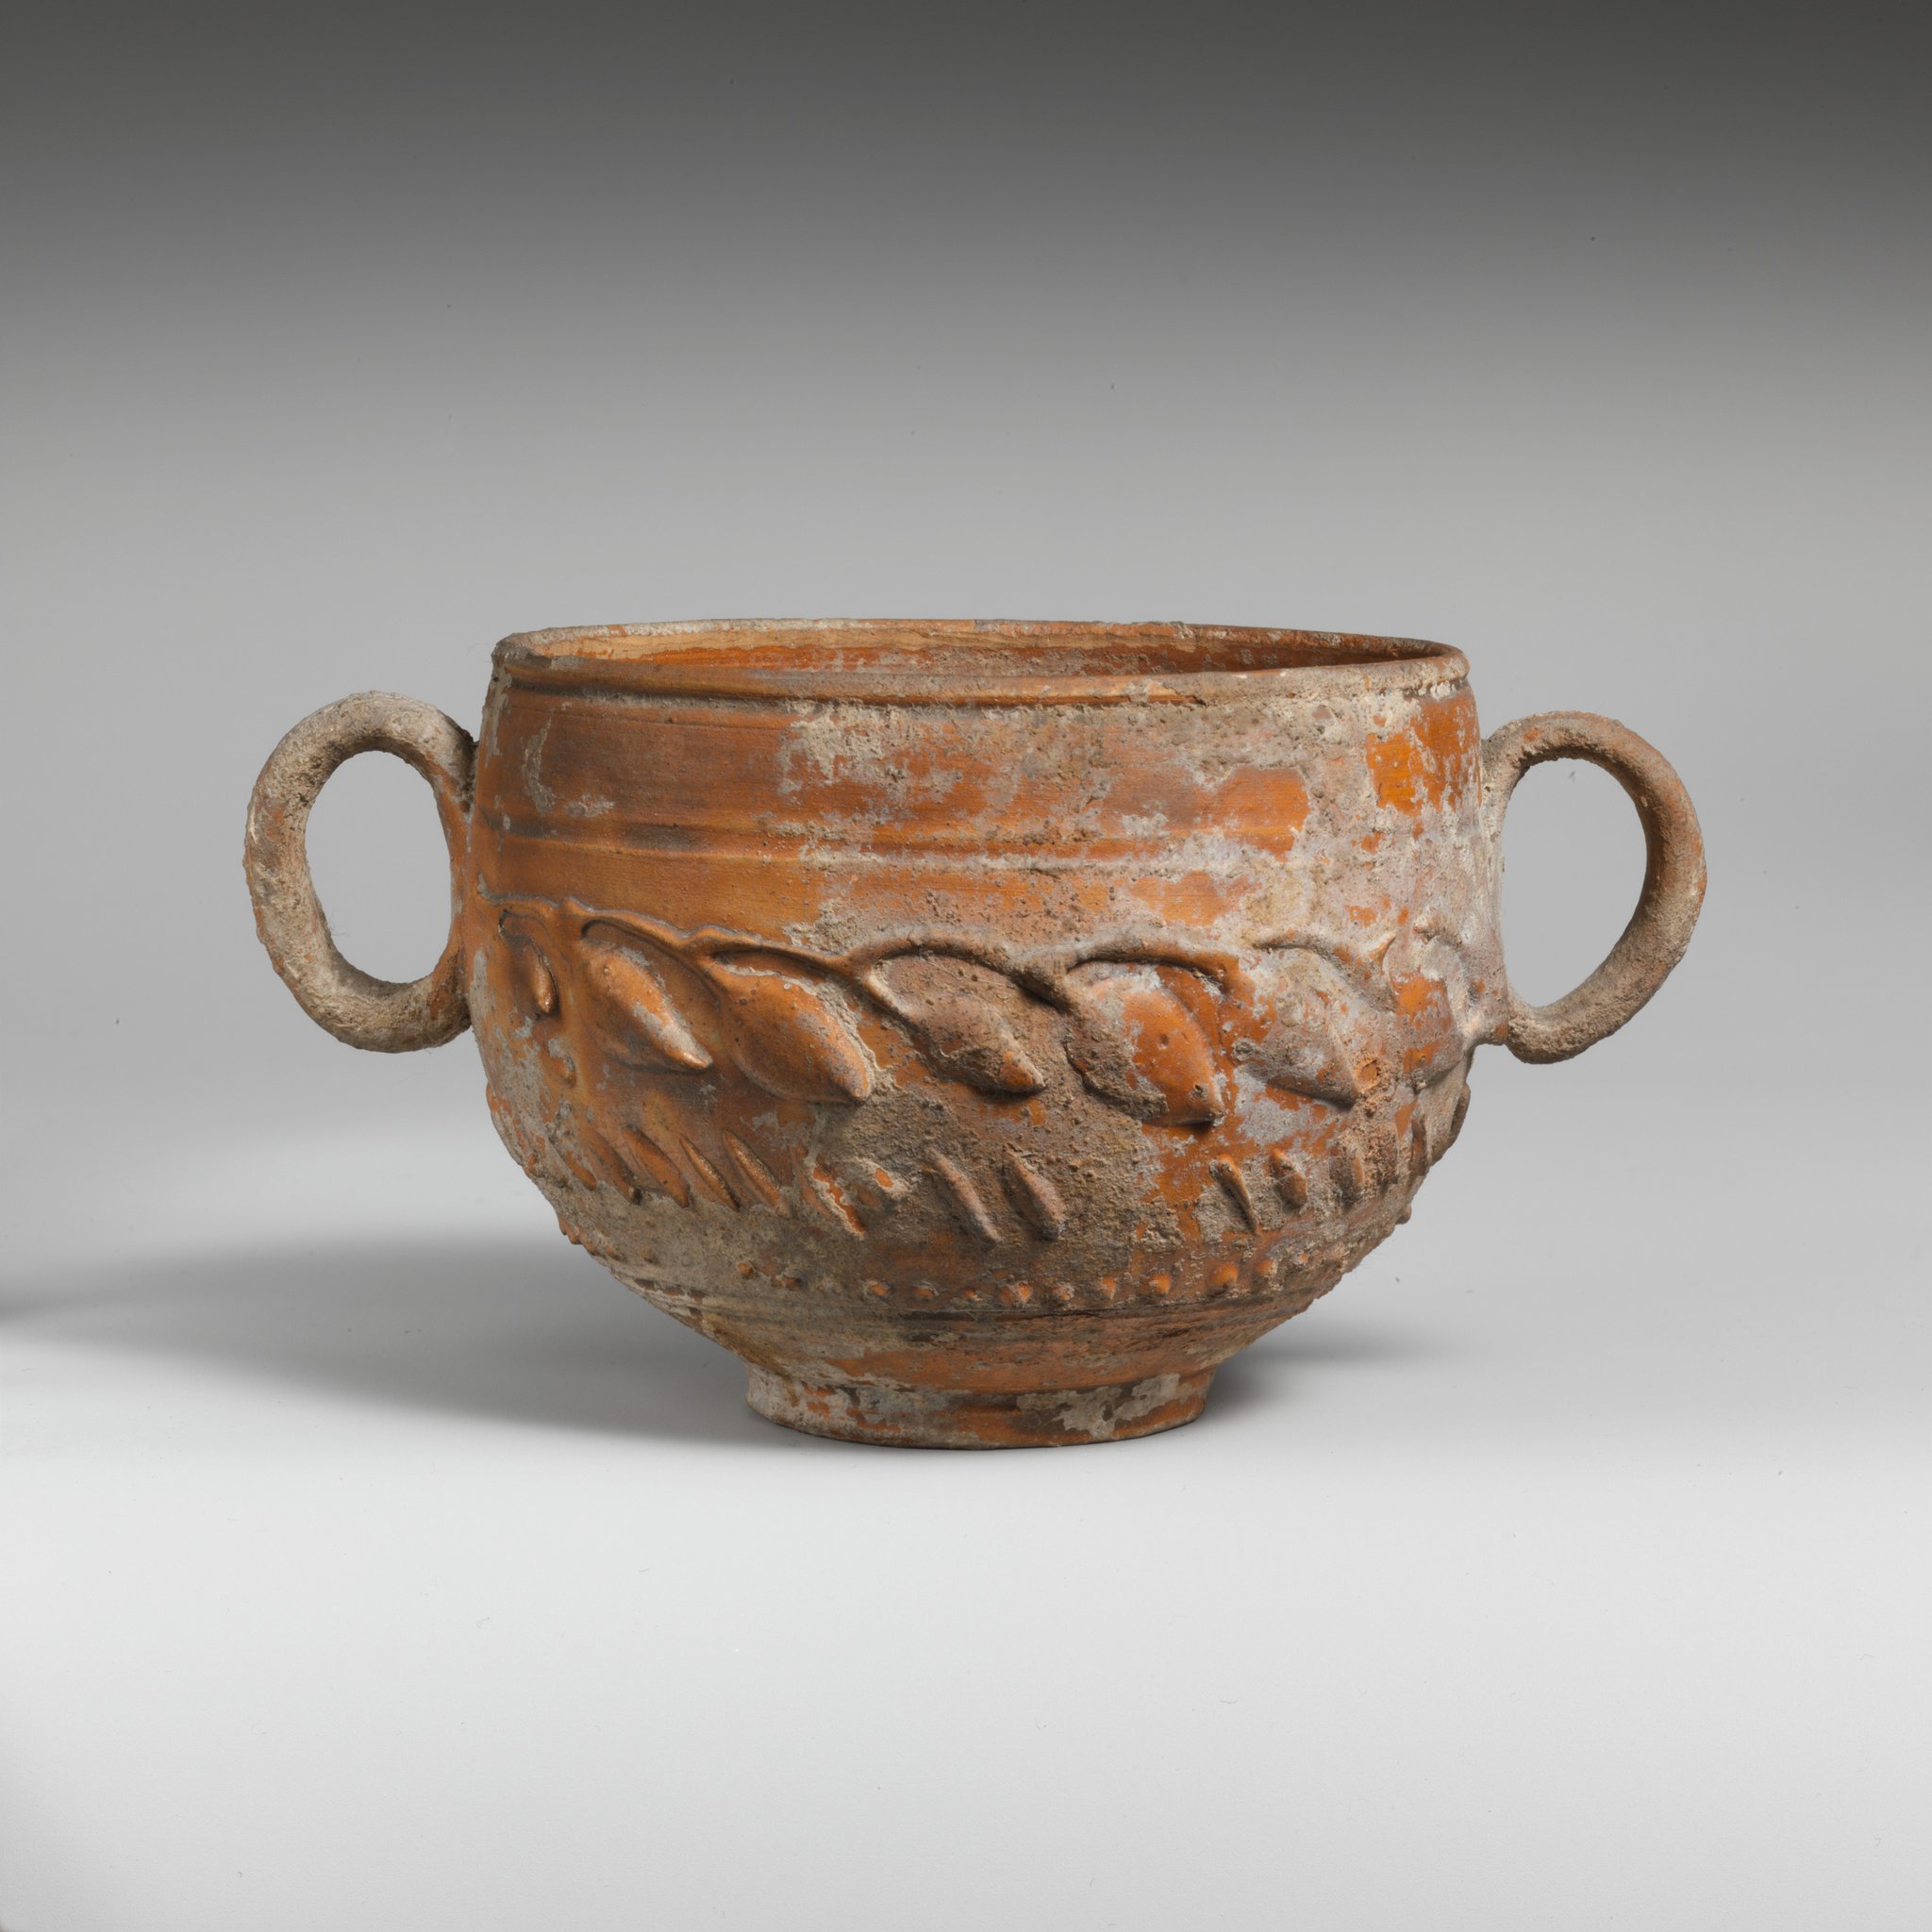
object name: skyphos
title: Terracotta scyphus (drinking cup) with barbotine decoration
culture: roman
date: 1-100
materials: terracotta